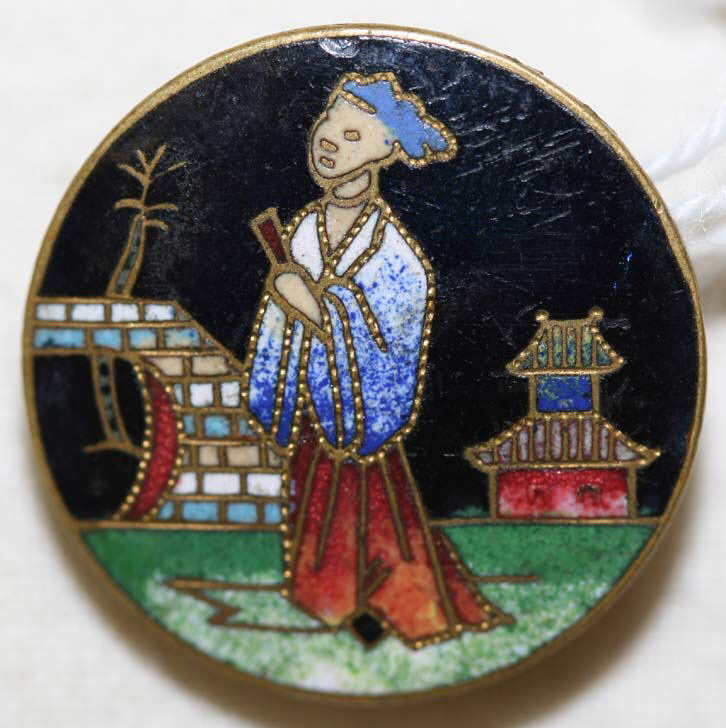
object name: stud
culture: american or european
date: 1834-1866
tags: human figures